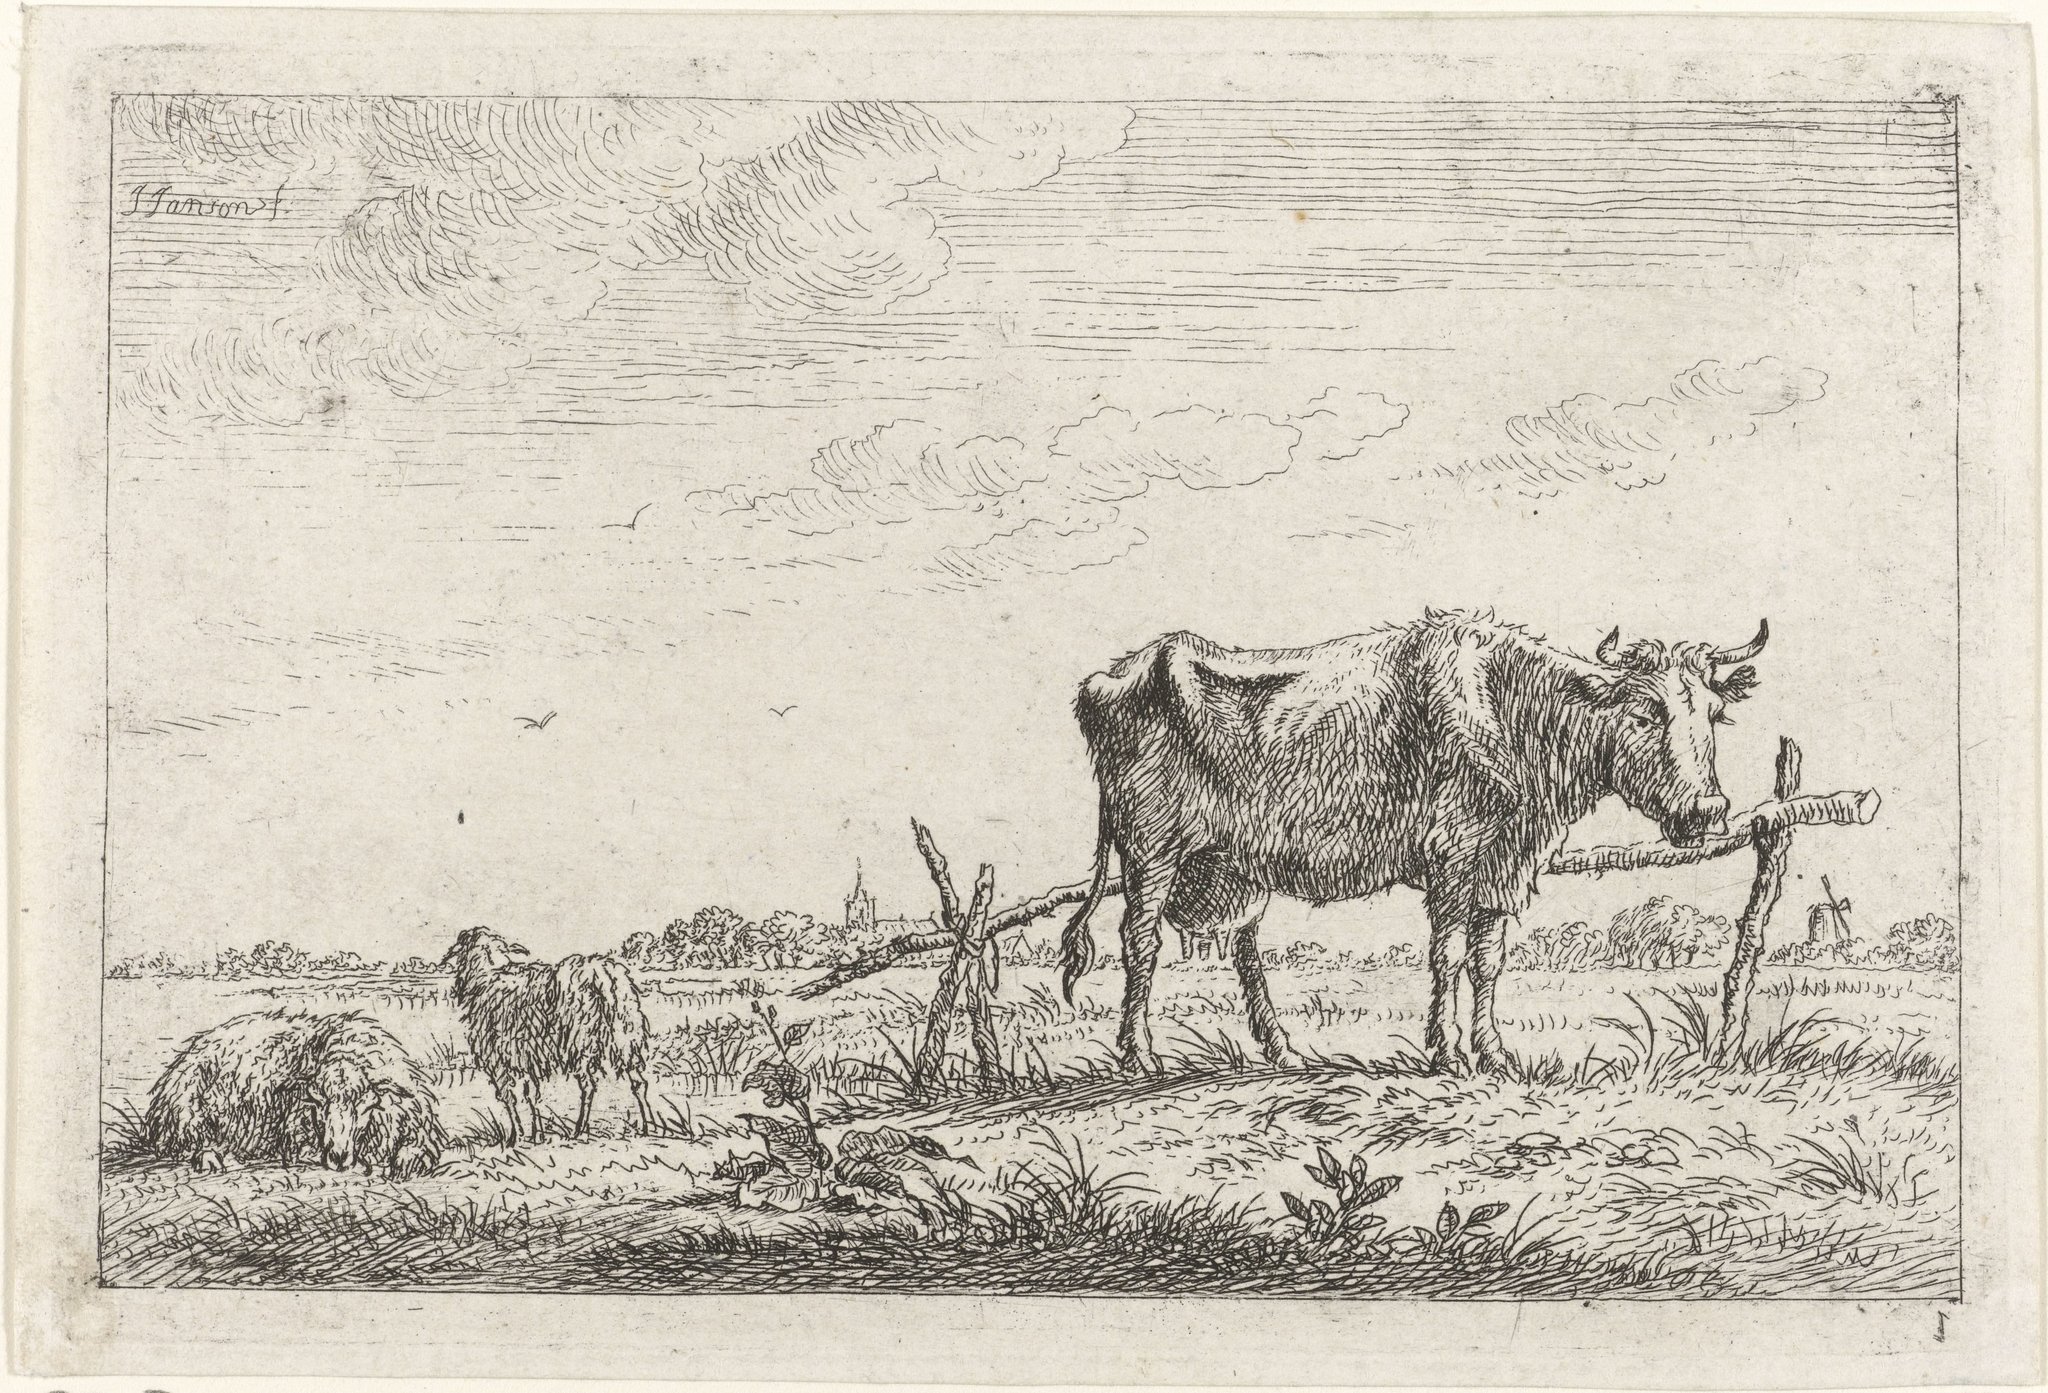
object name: print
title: Landschappen met vee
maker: johannes janson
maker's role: draughtsman, painter, print maker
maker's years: 1729-1784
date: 1761-1784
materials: paper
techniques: etching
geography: leiden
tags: cow, sheep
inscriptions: collector's mark: Lugt 2228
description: Weiland met koe, staand bij een hek, en twee schapen. Eerste prent uit een serie van acht met landschappen met vee.